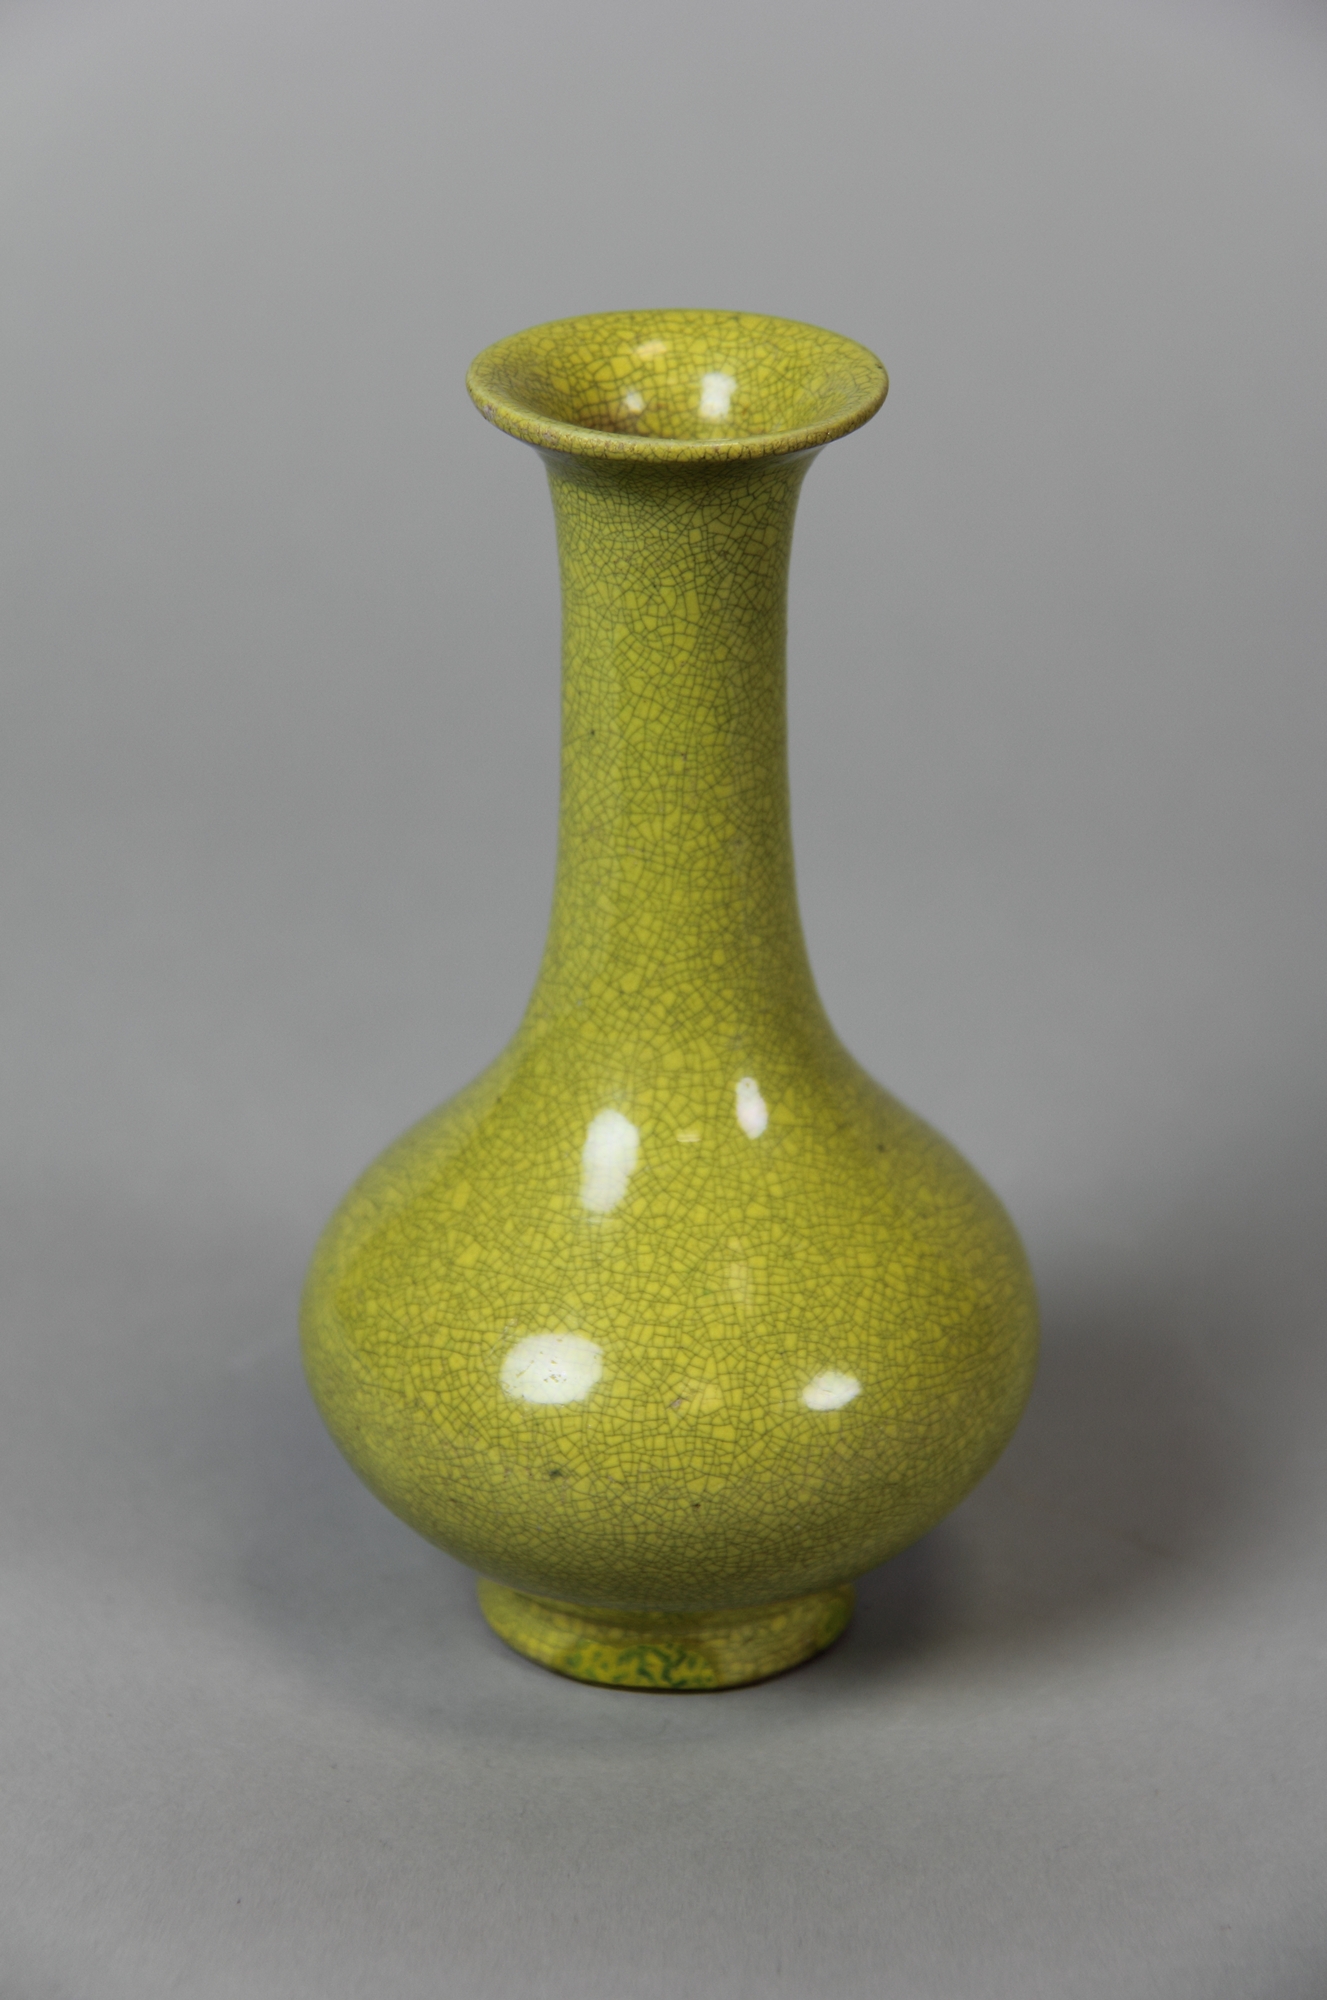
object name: vase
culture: chinese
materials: enamel, glaze, porcelain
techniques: overglaze